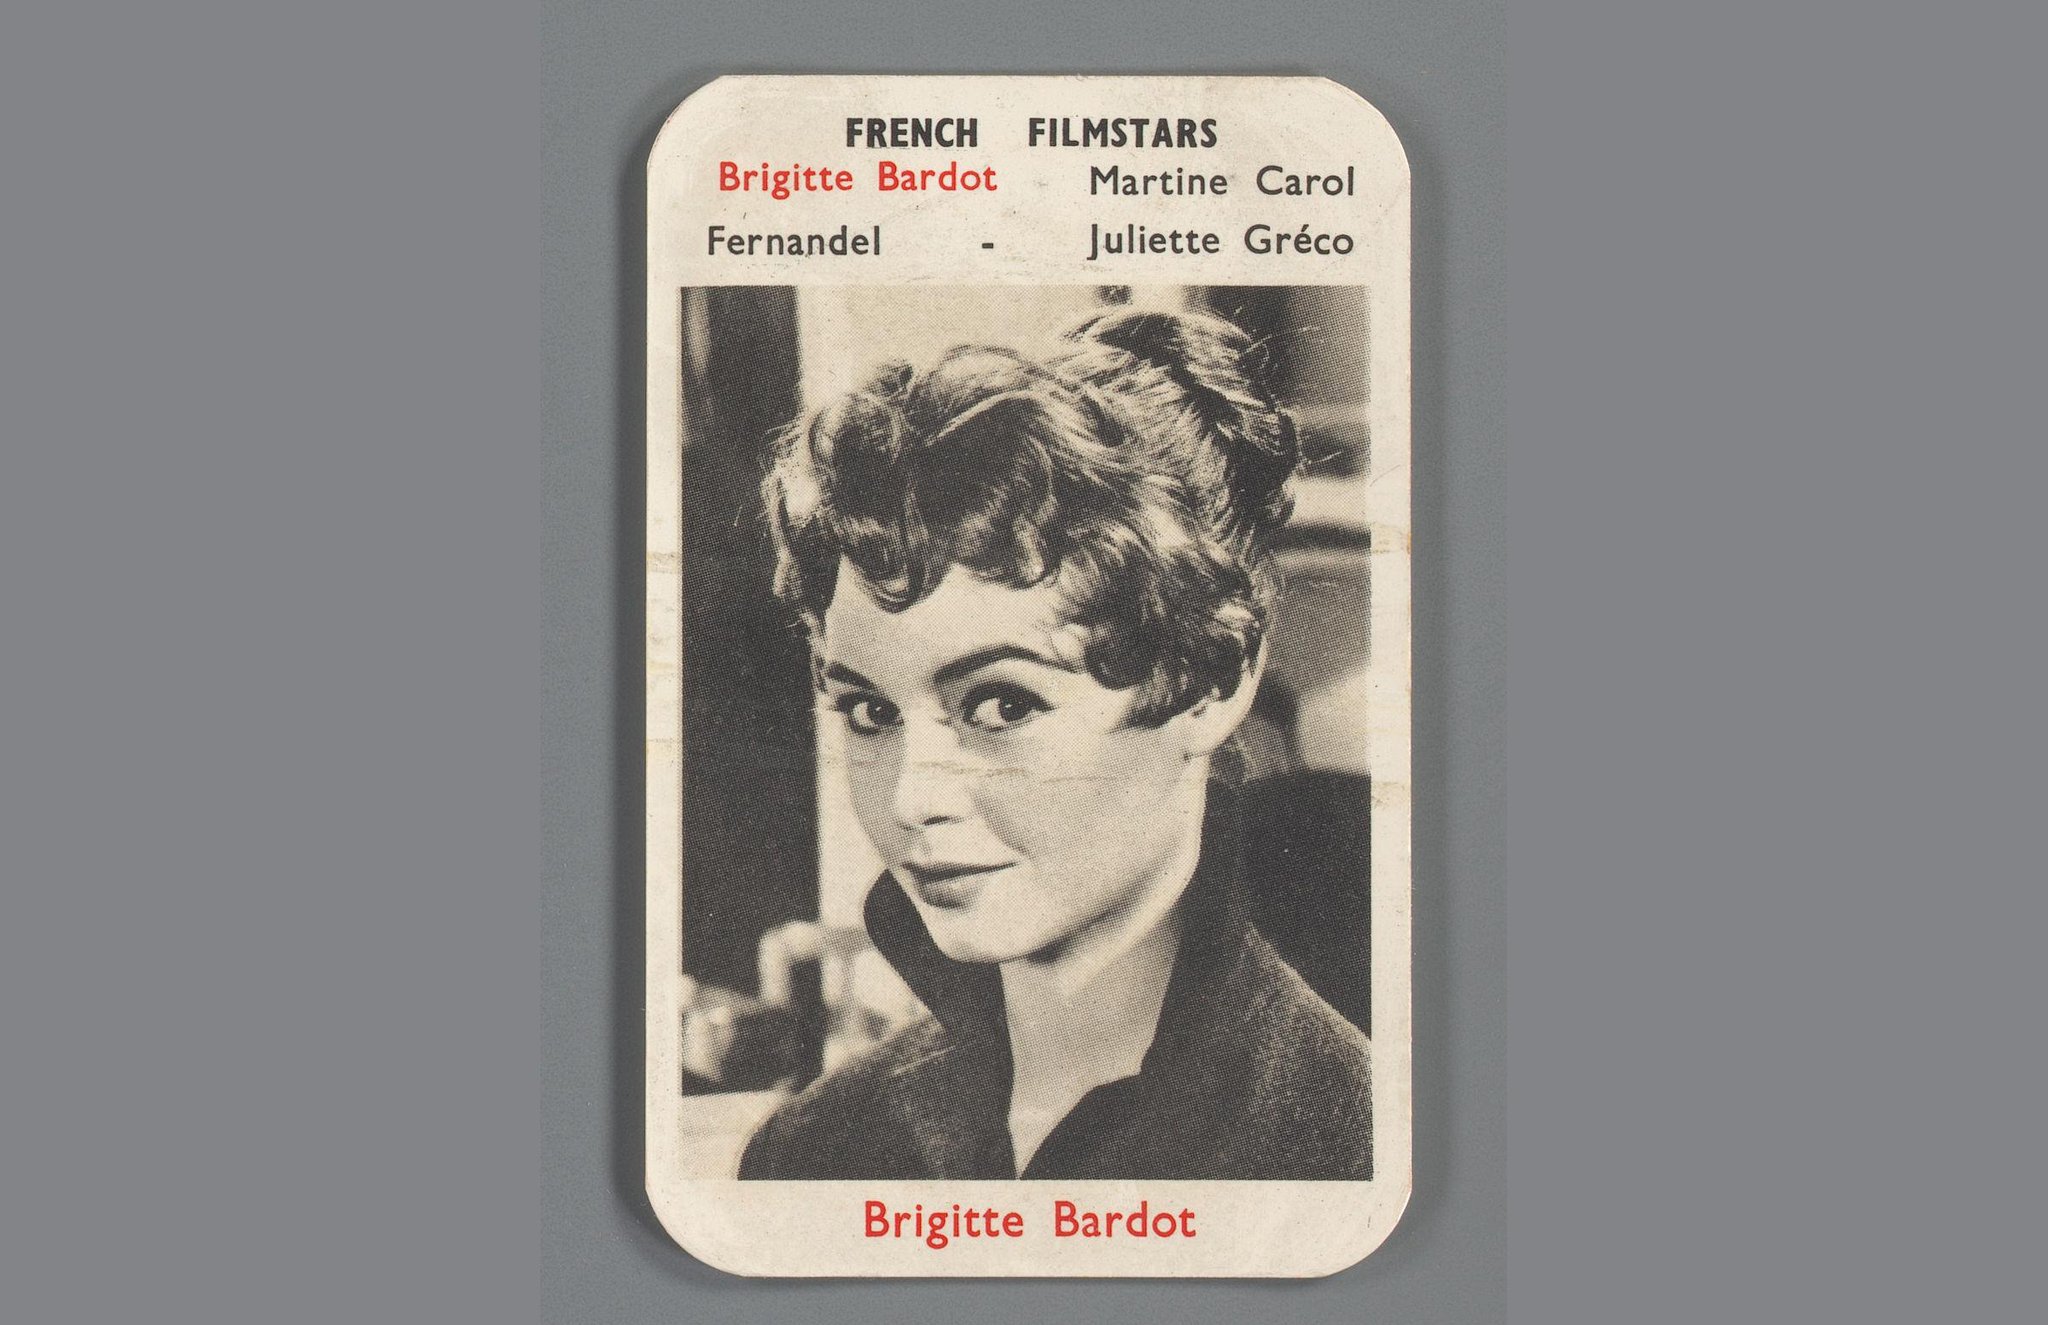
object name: photomechanical print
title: Brigitte Bardot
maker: Anonymous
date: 1960-1970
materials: paper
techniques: autotype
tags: paris, portrait of actor, actress